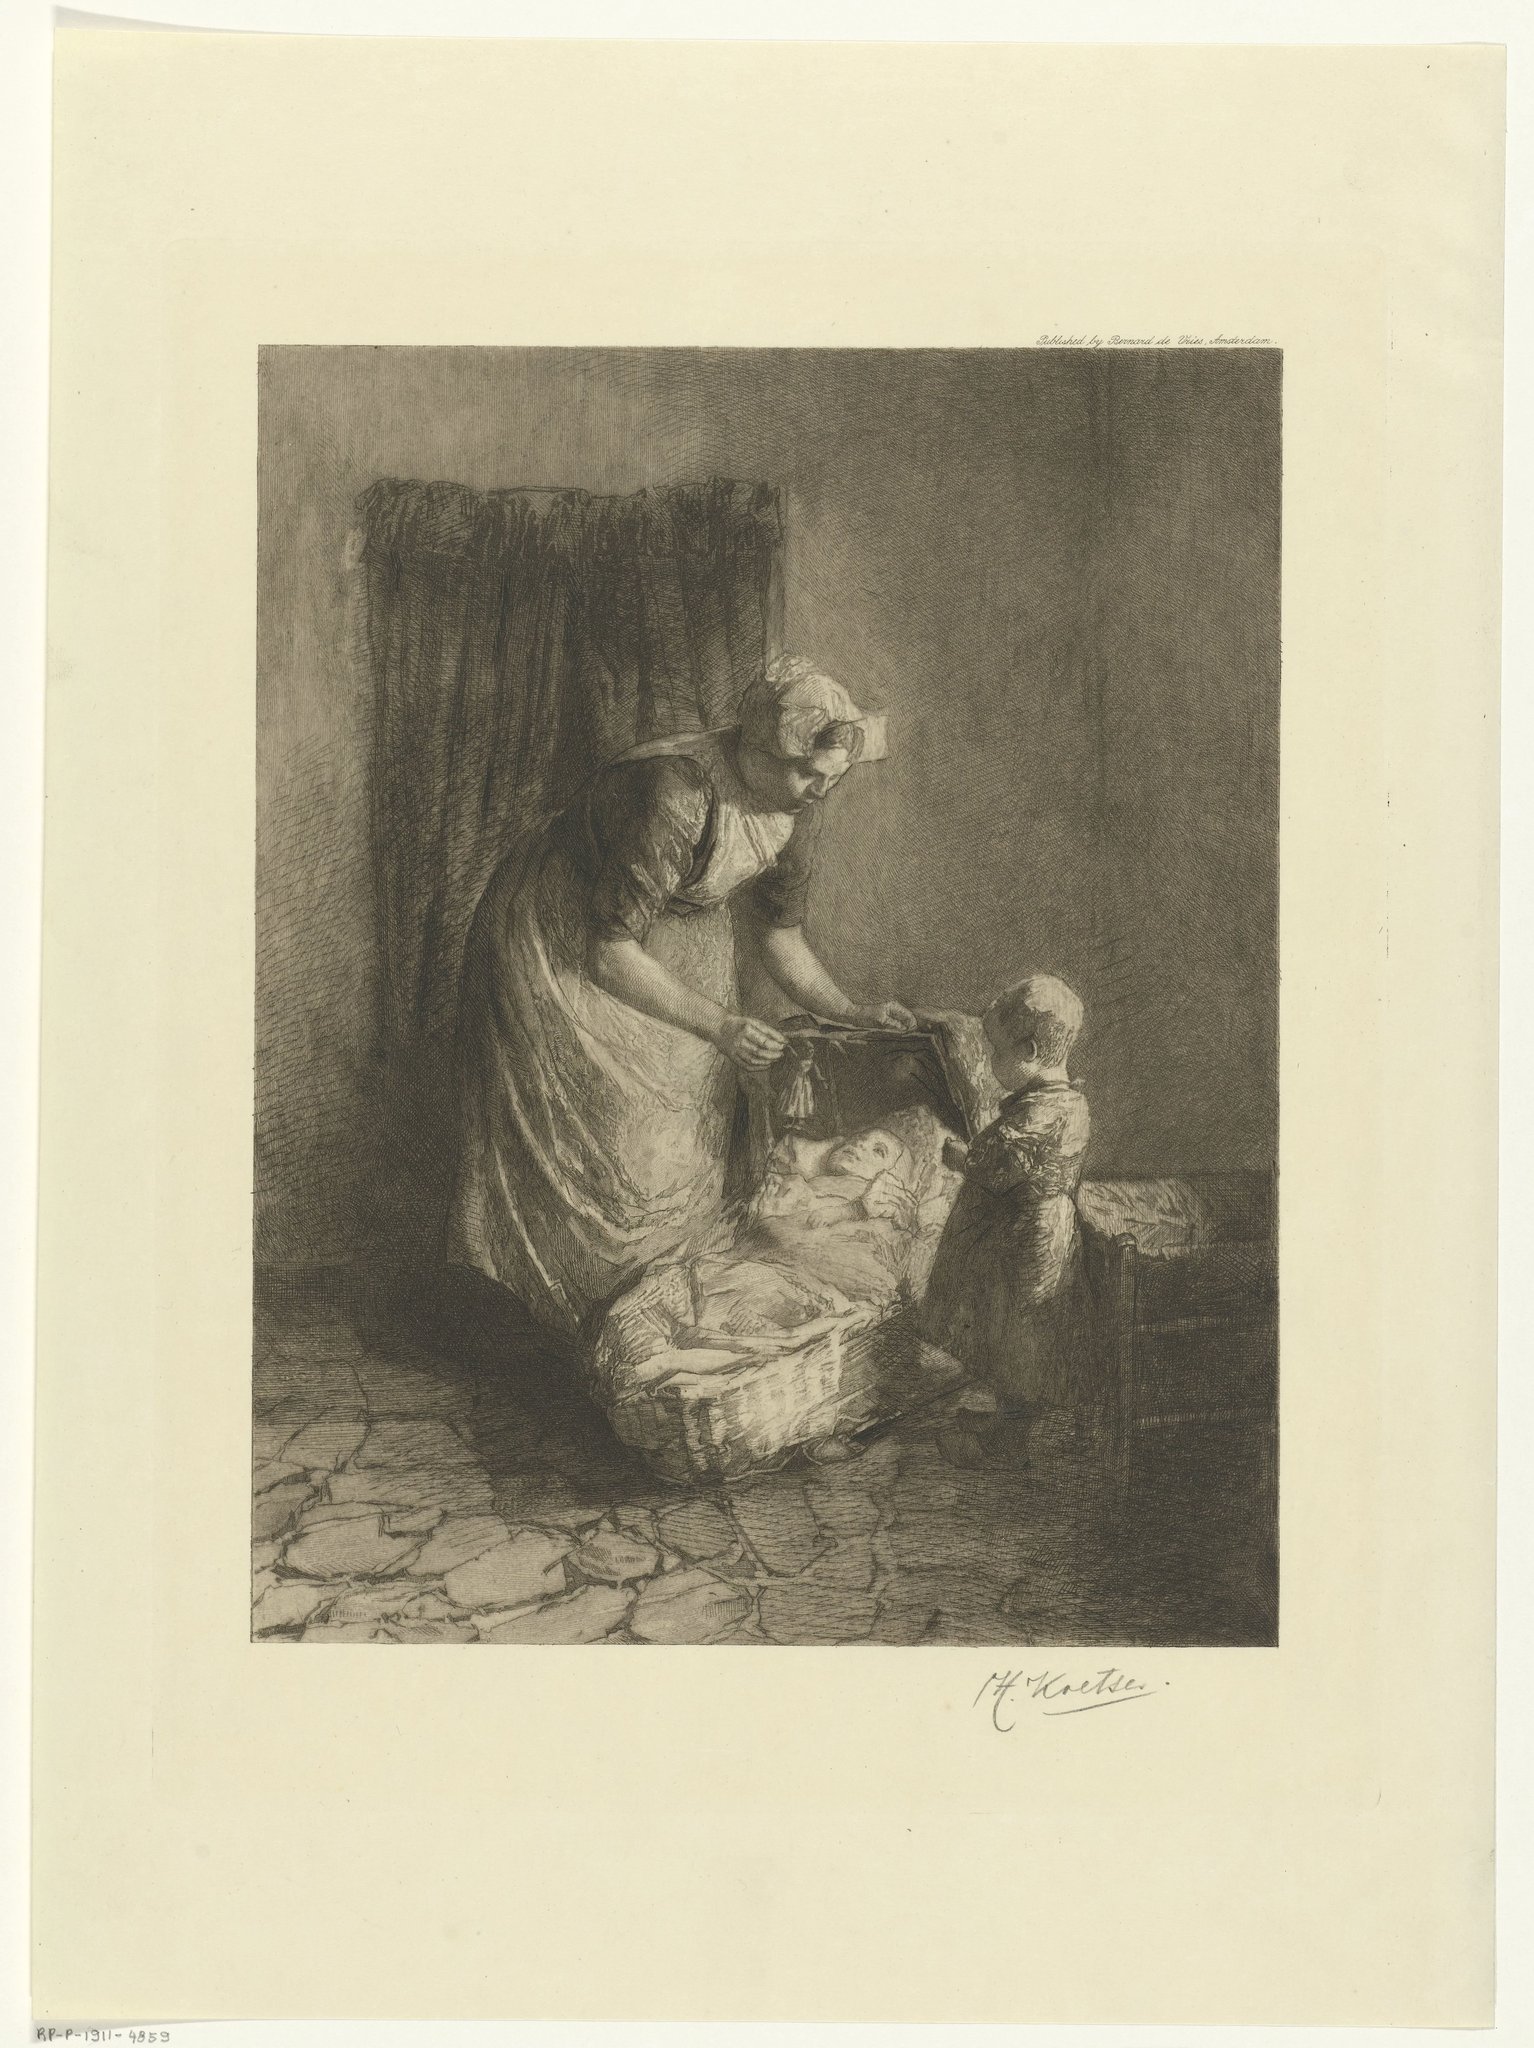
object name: print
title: Boerin bij een wieg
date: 1888-1911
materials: paper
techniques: etching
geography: amsterdam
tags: farmers - aa - female farmer, farmer's wife, cradle, crib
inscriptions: collector's mark: Lugt 2228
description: In een sober vertrek staan een boerin en een kind bij een wieg waar een baby in ligt. De boerin staat over de wieg gebogen om een poppetje aan de baby te tonen. Achter haar hangt een gordijn.